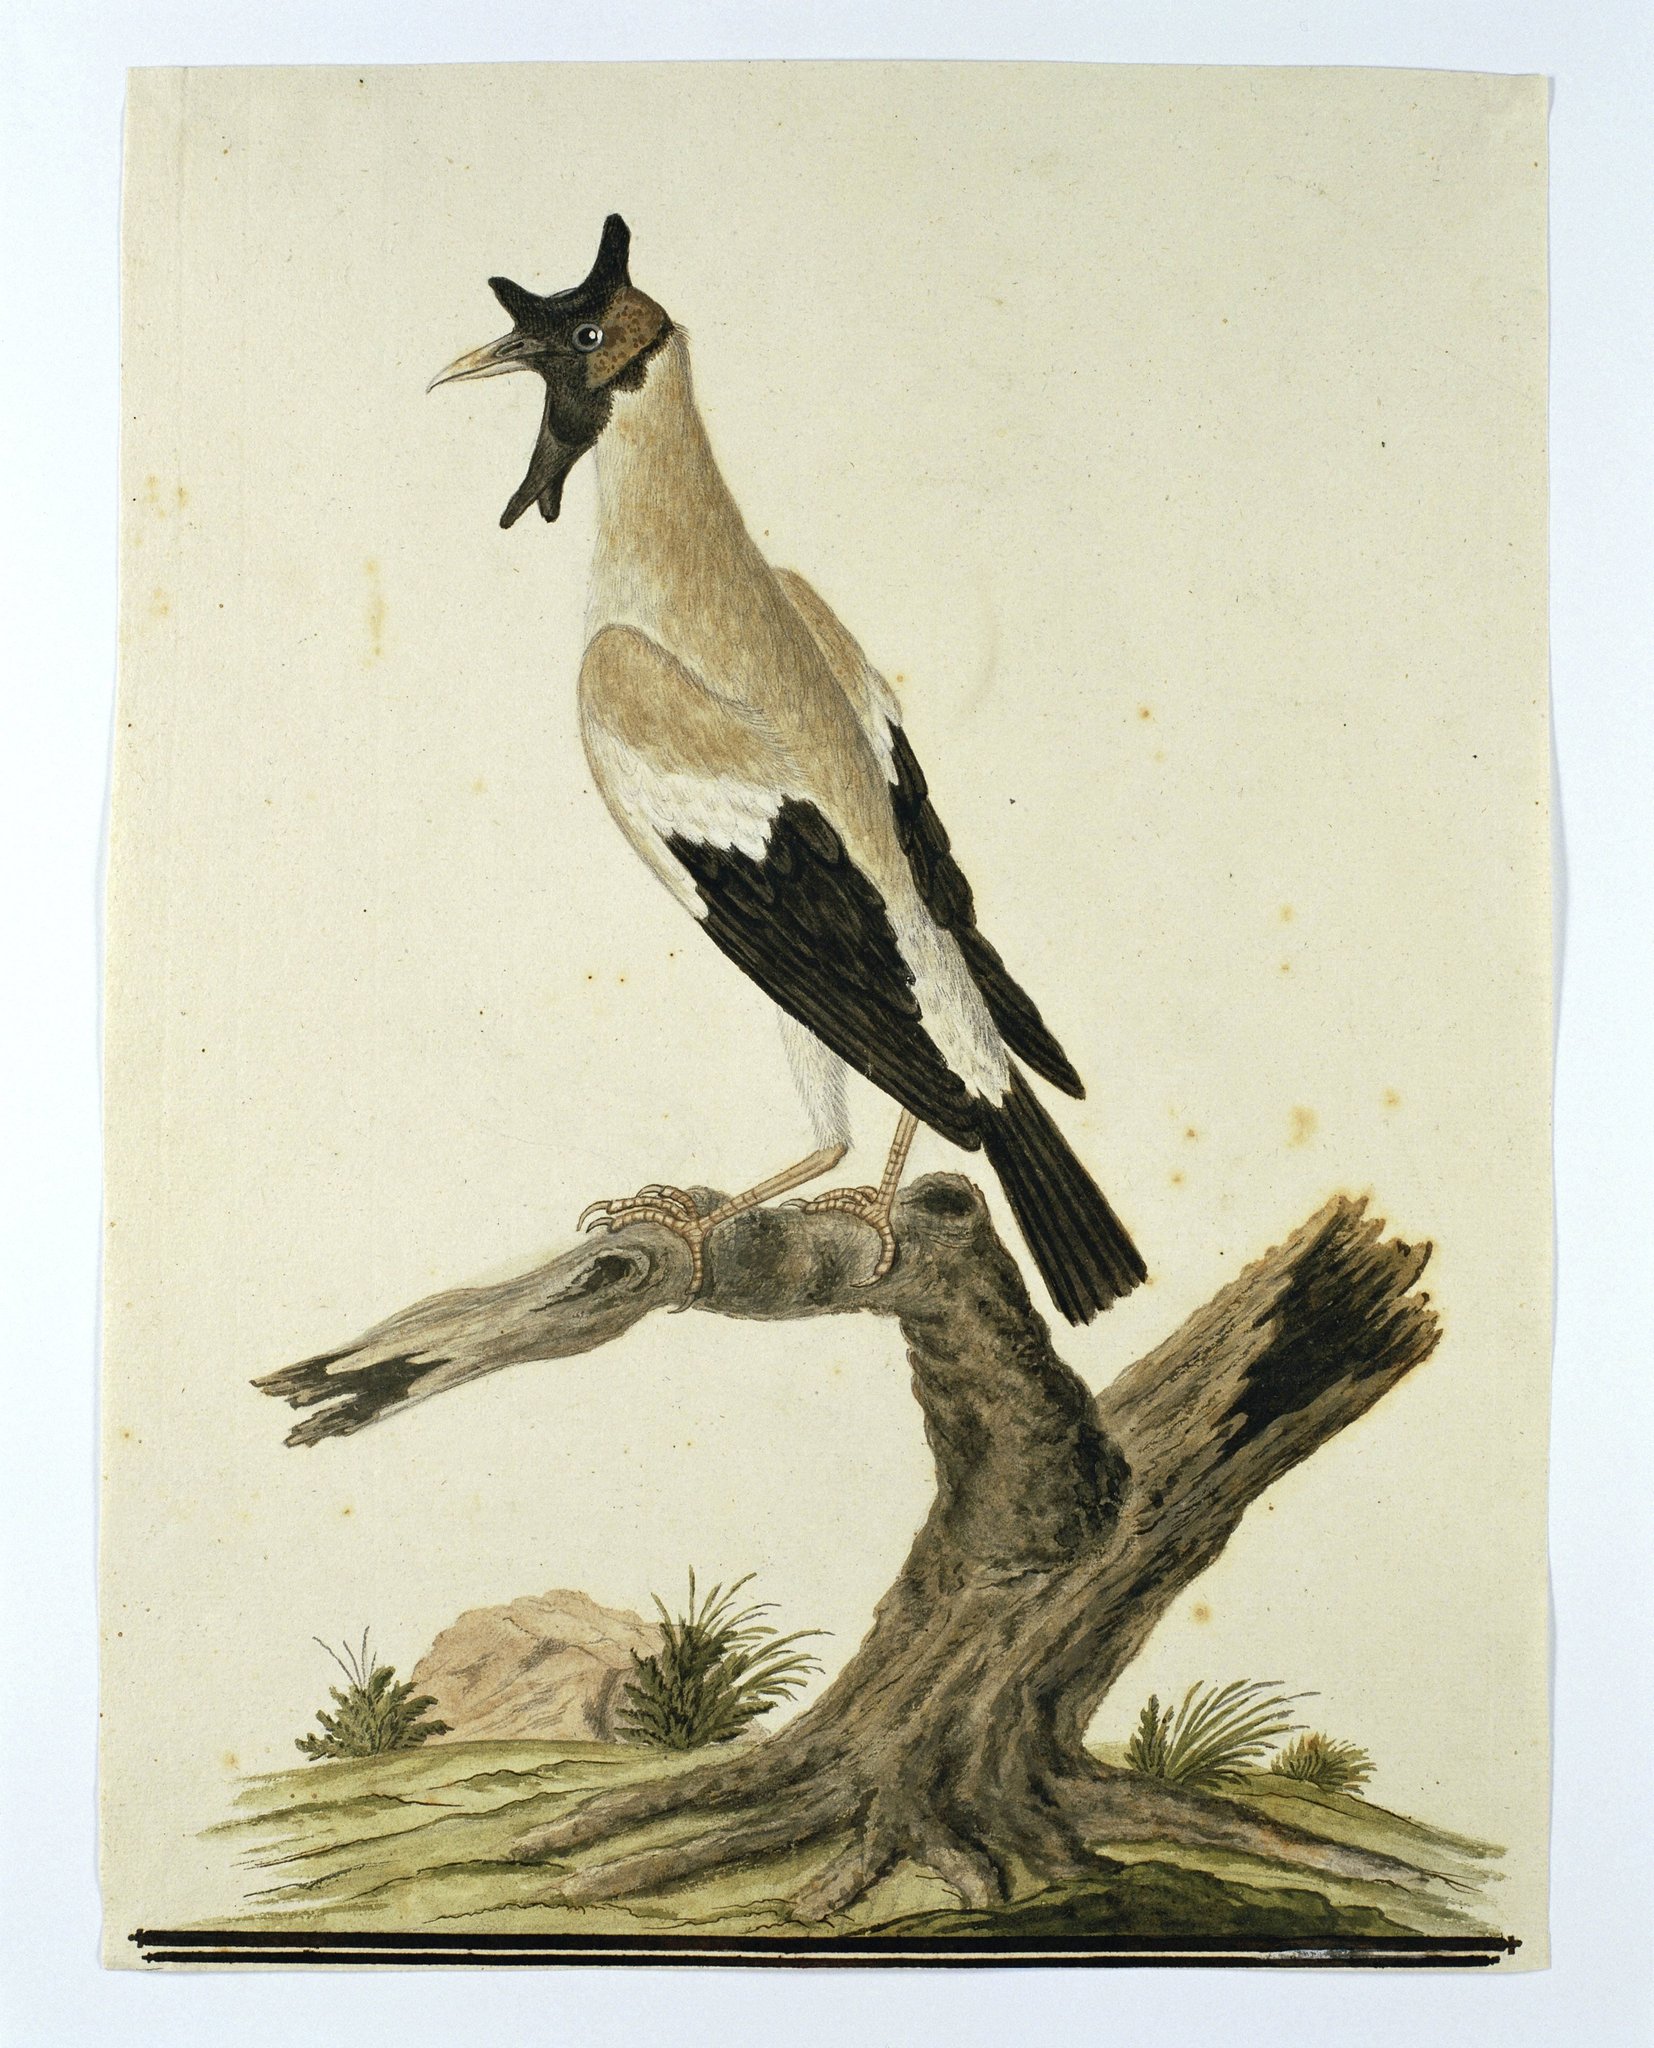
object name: drawing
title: Creatophora cinerea (Wattled starling)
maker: robert jacob gordon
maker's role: draughtsman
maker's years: 1743-1795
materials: paint, ink, paper, pencil, watercolor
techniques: brush, pen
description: Vogelstudie: Lelspreeuw (Creatophora cinerea): een mannetje.